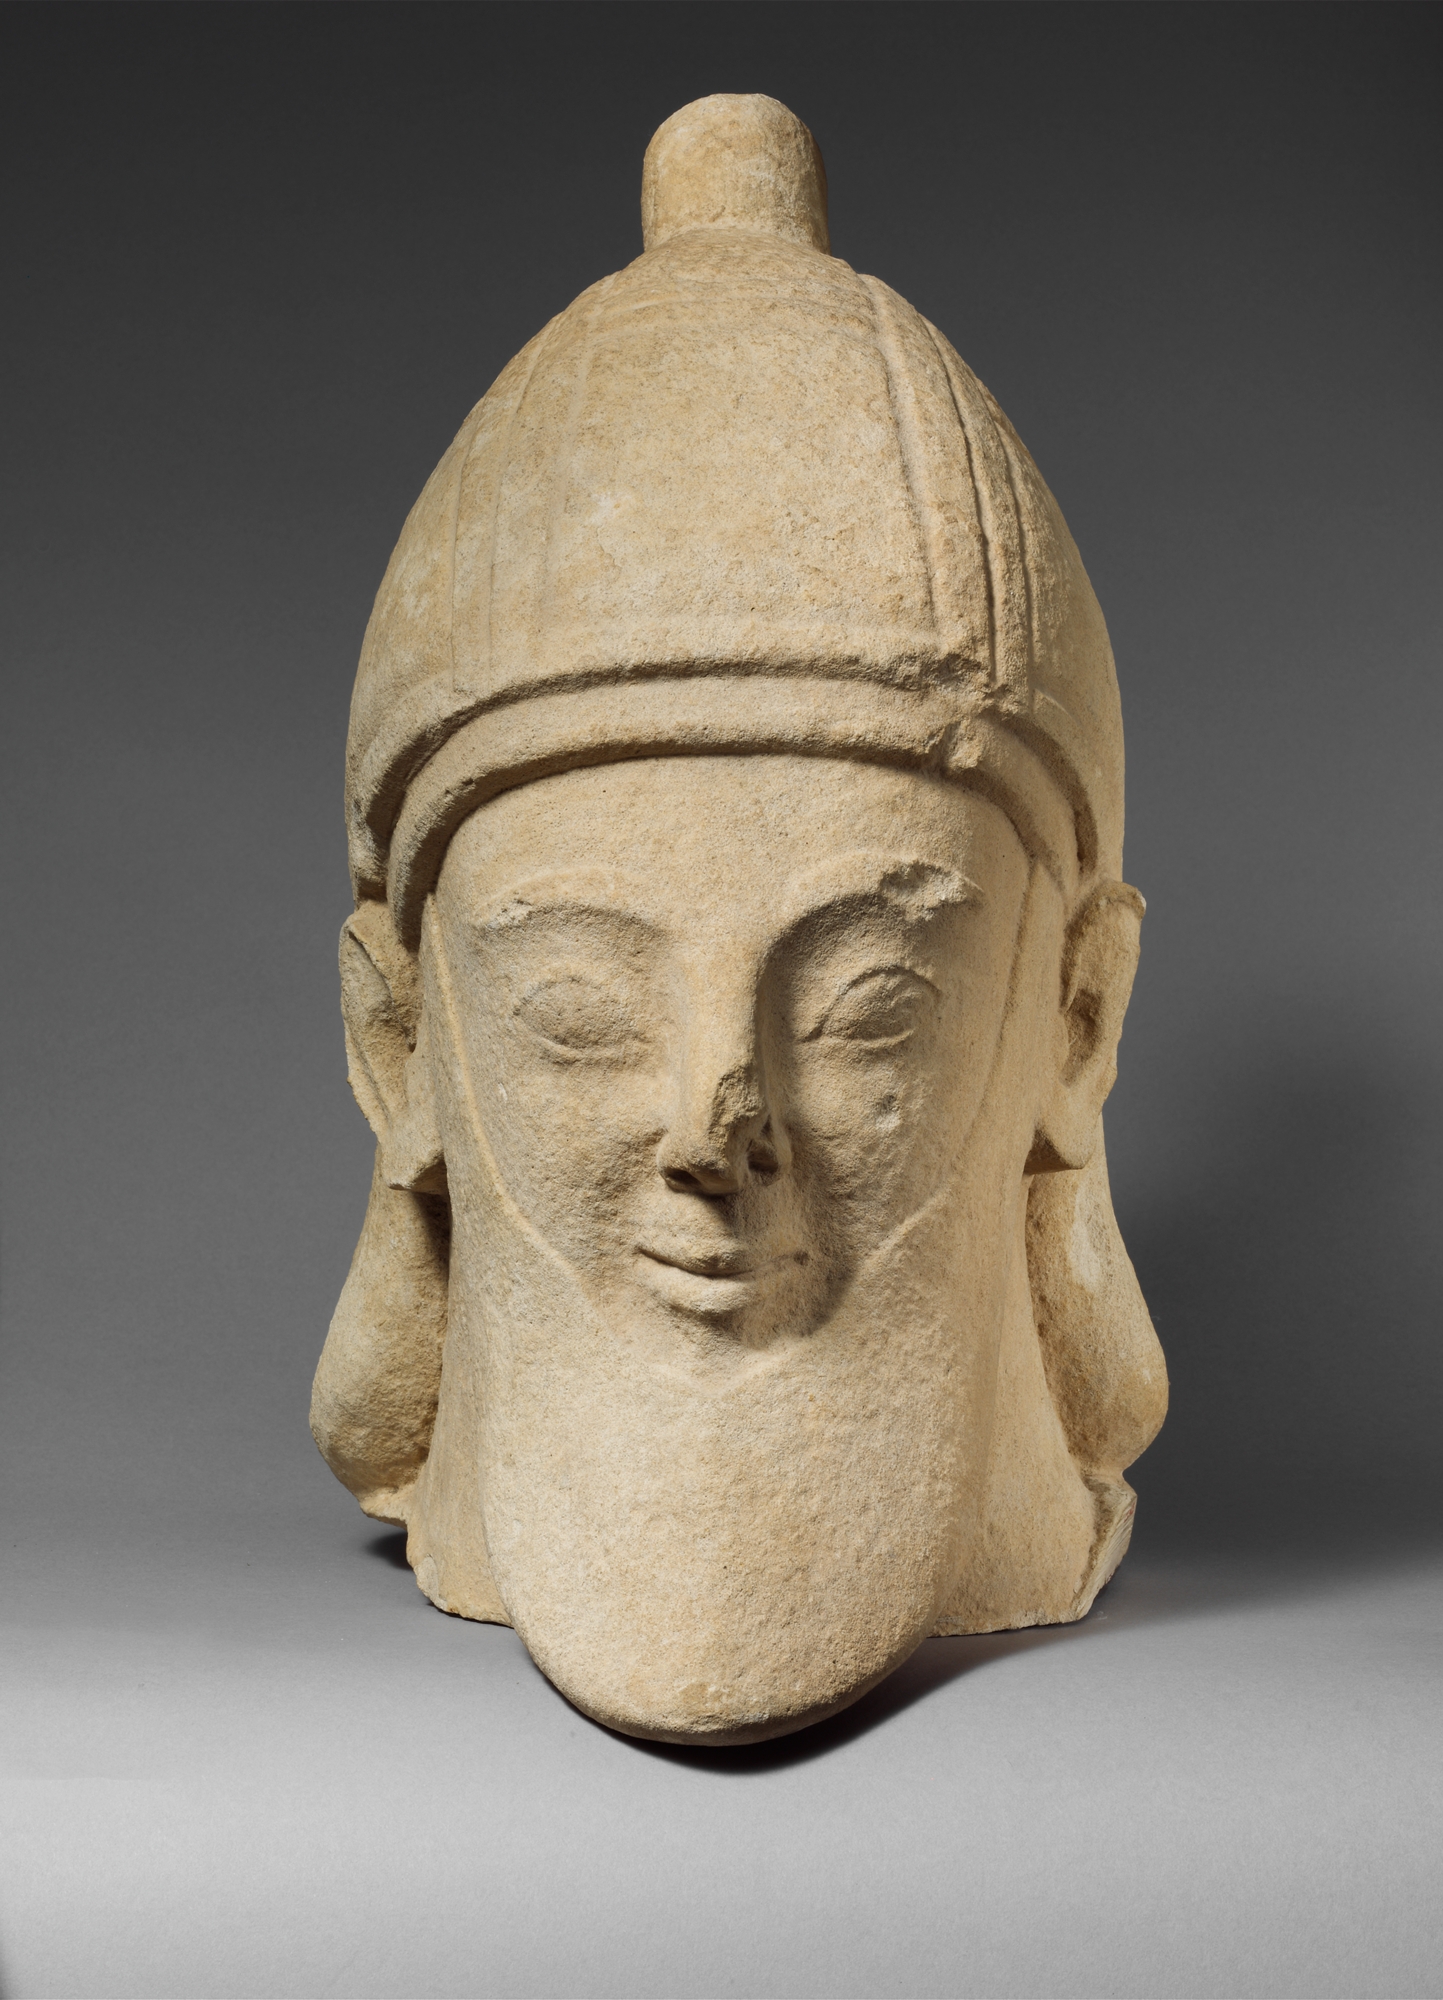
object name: head of a warrior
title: Limestone head of a bearded male wearing a conical helmet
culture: cypriot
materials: limestone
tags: helmets,heads,men